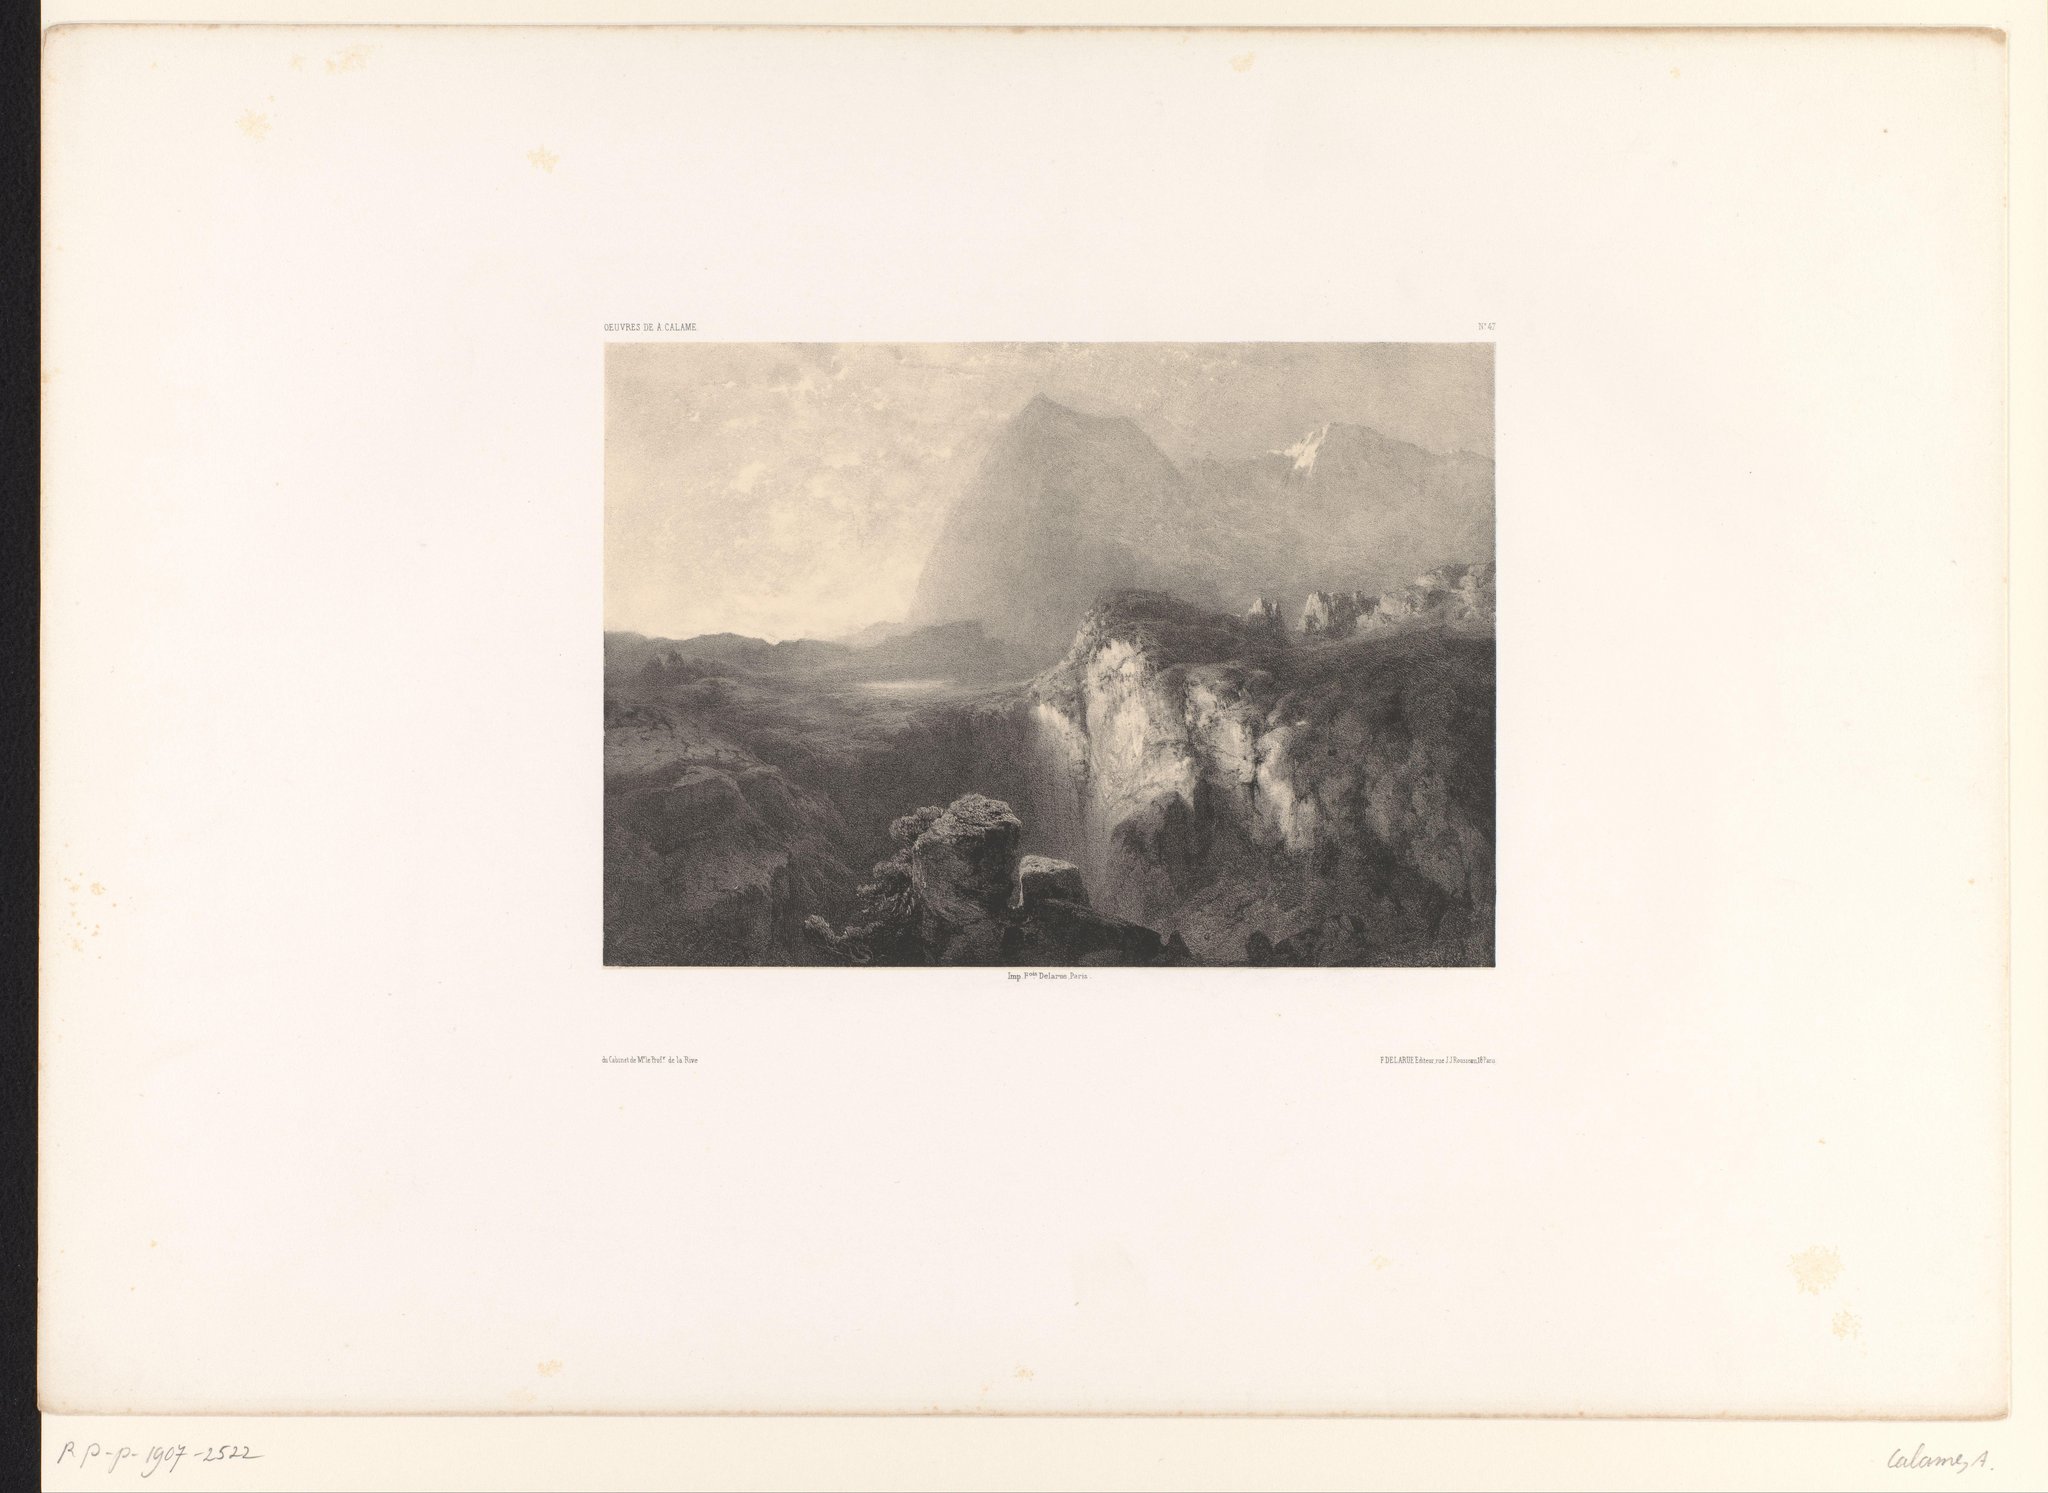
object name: print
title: Oeuvres de A. Calame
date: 1852-1855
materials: paper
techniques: lithograph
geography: paris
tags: ravine, chasm, abyss, canyon, sunlight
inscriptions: collector's mark: Lugt 2228a